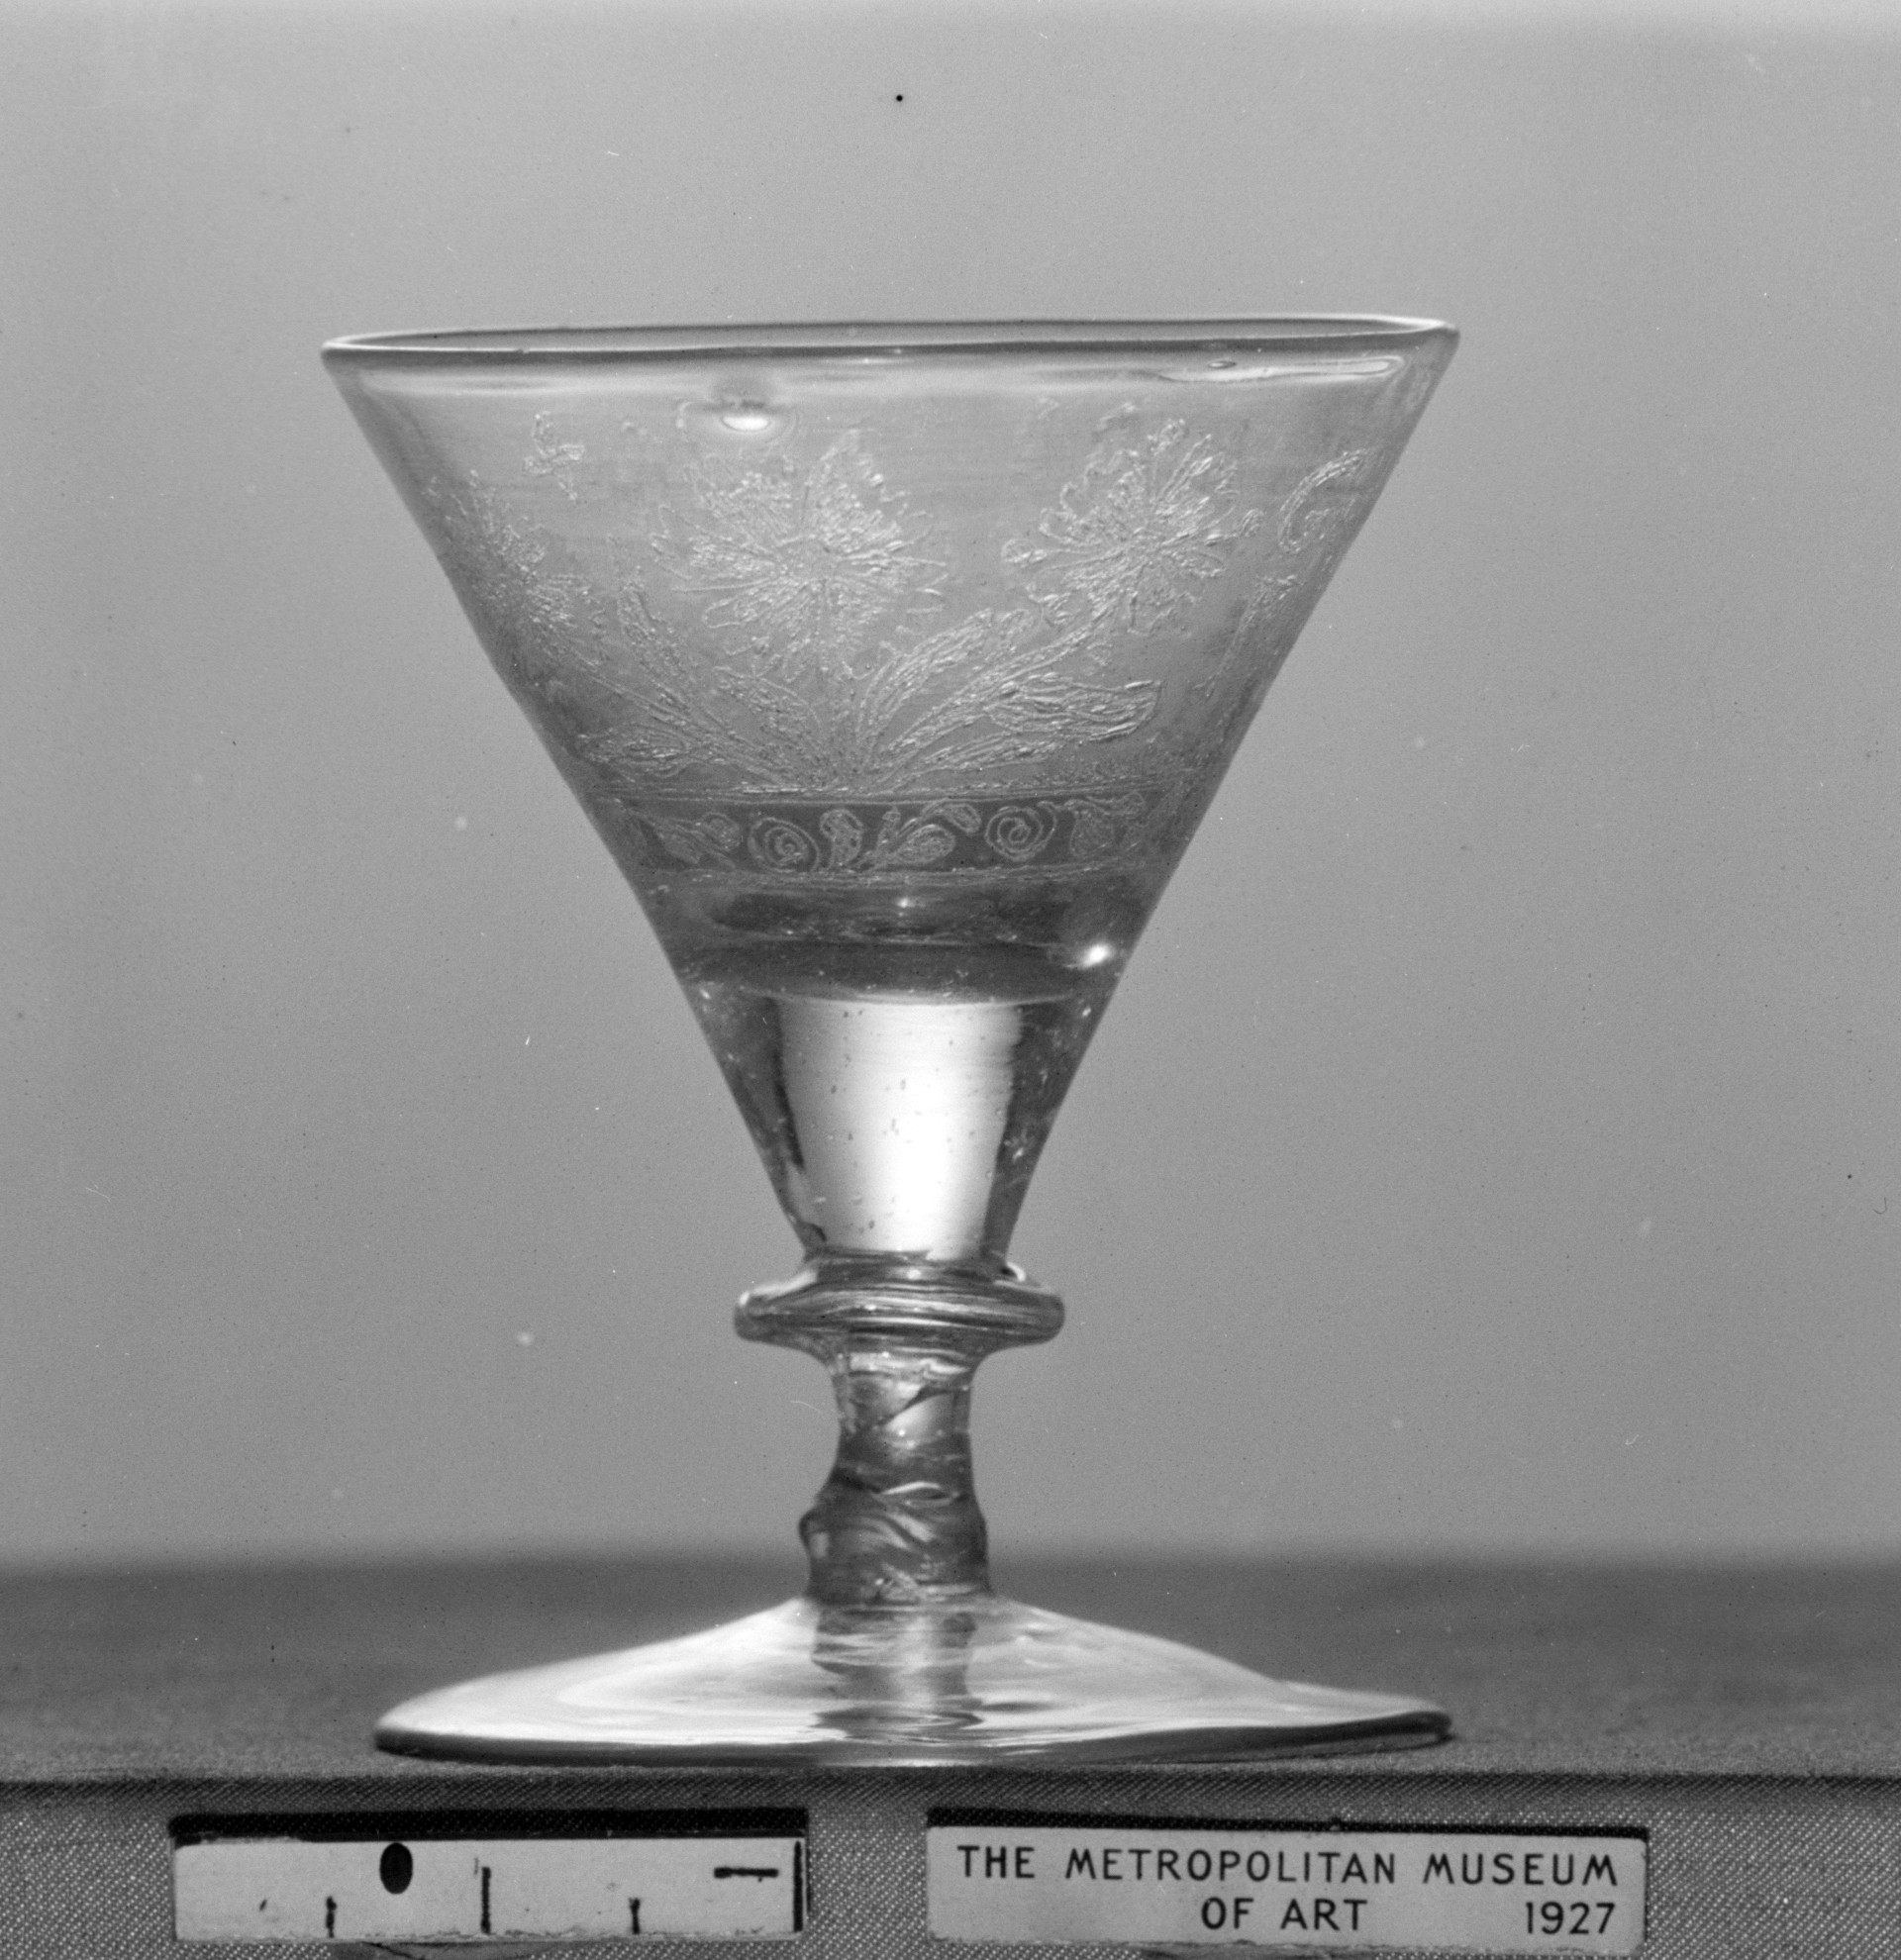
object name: liqueur glass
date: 1683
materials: glass